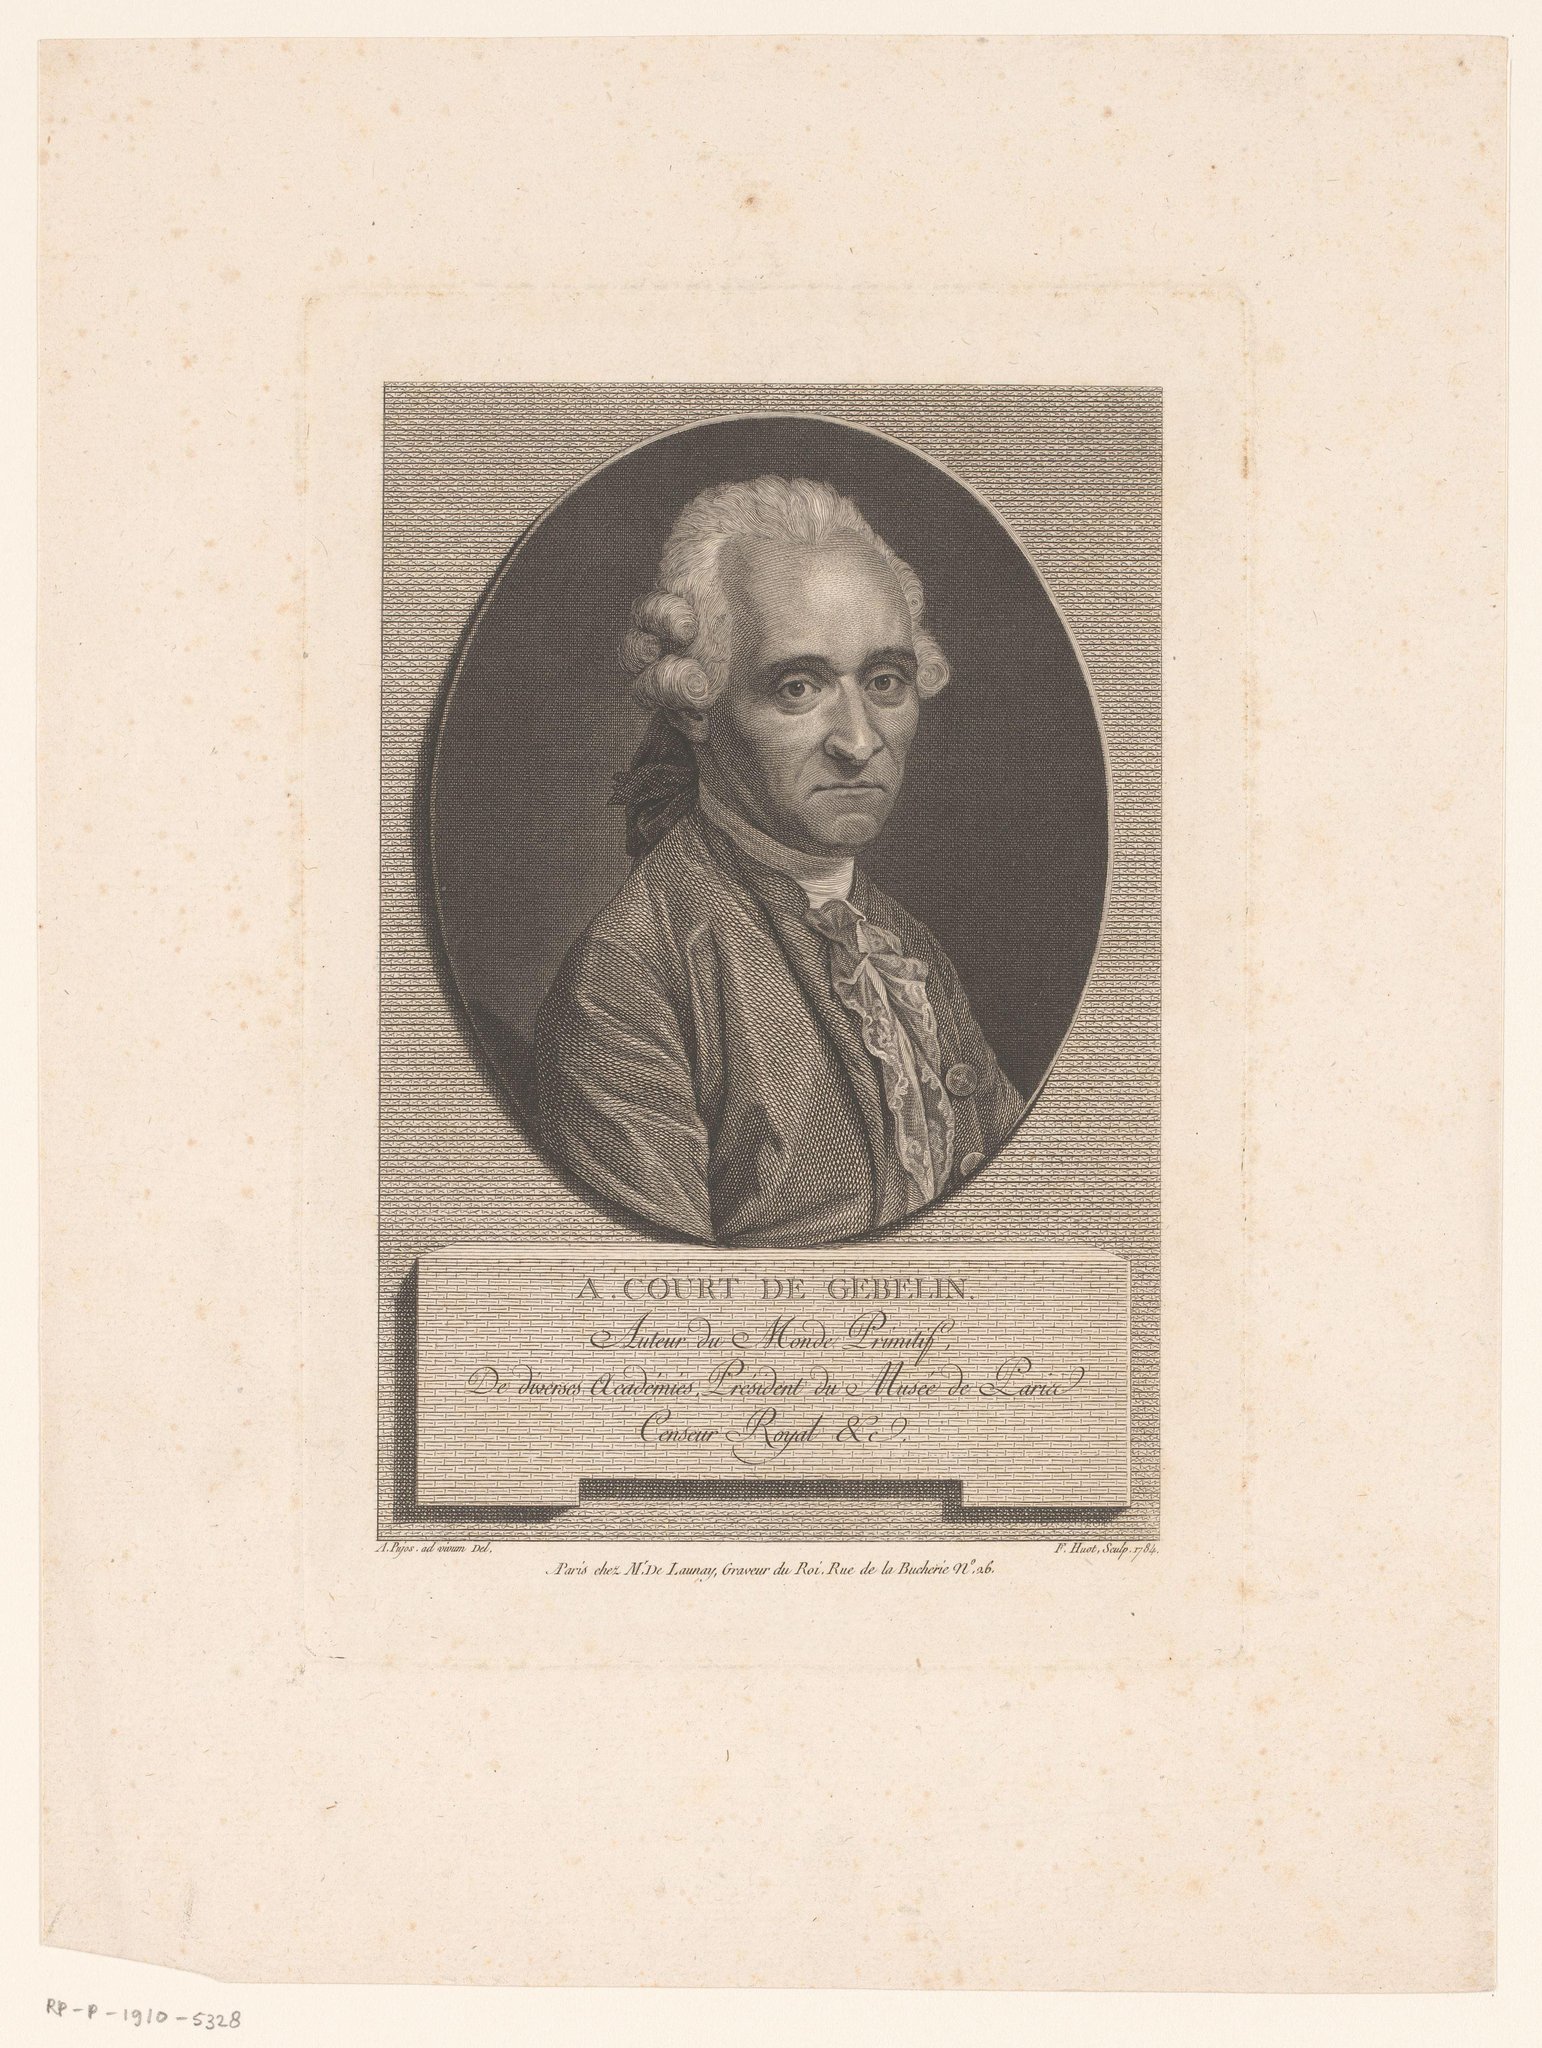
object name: print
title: Portret van Antoine Court de Gébelin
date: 1784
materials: paper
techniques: engraving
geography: paris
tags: historical persons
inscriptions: collector's mark: Lugt 2228